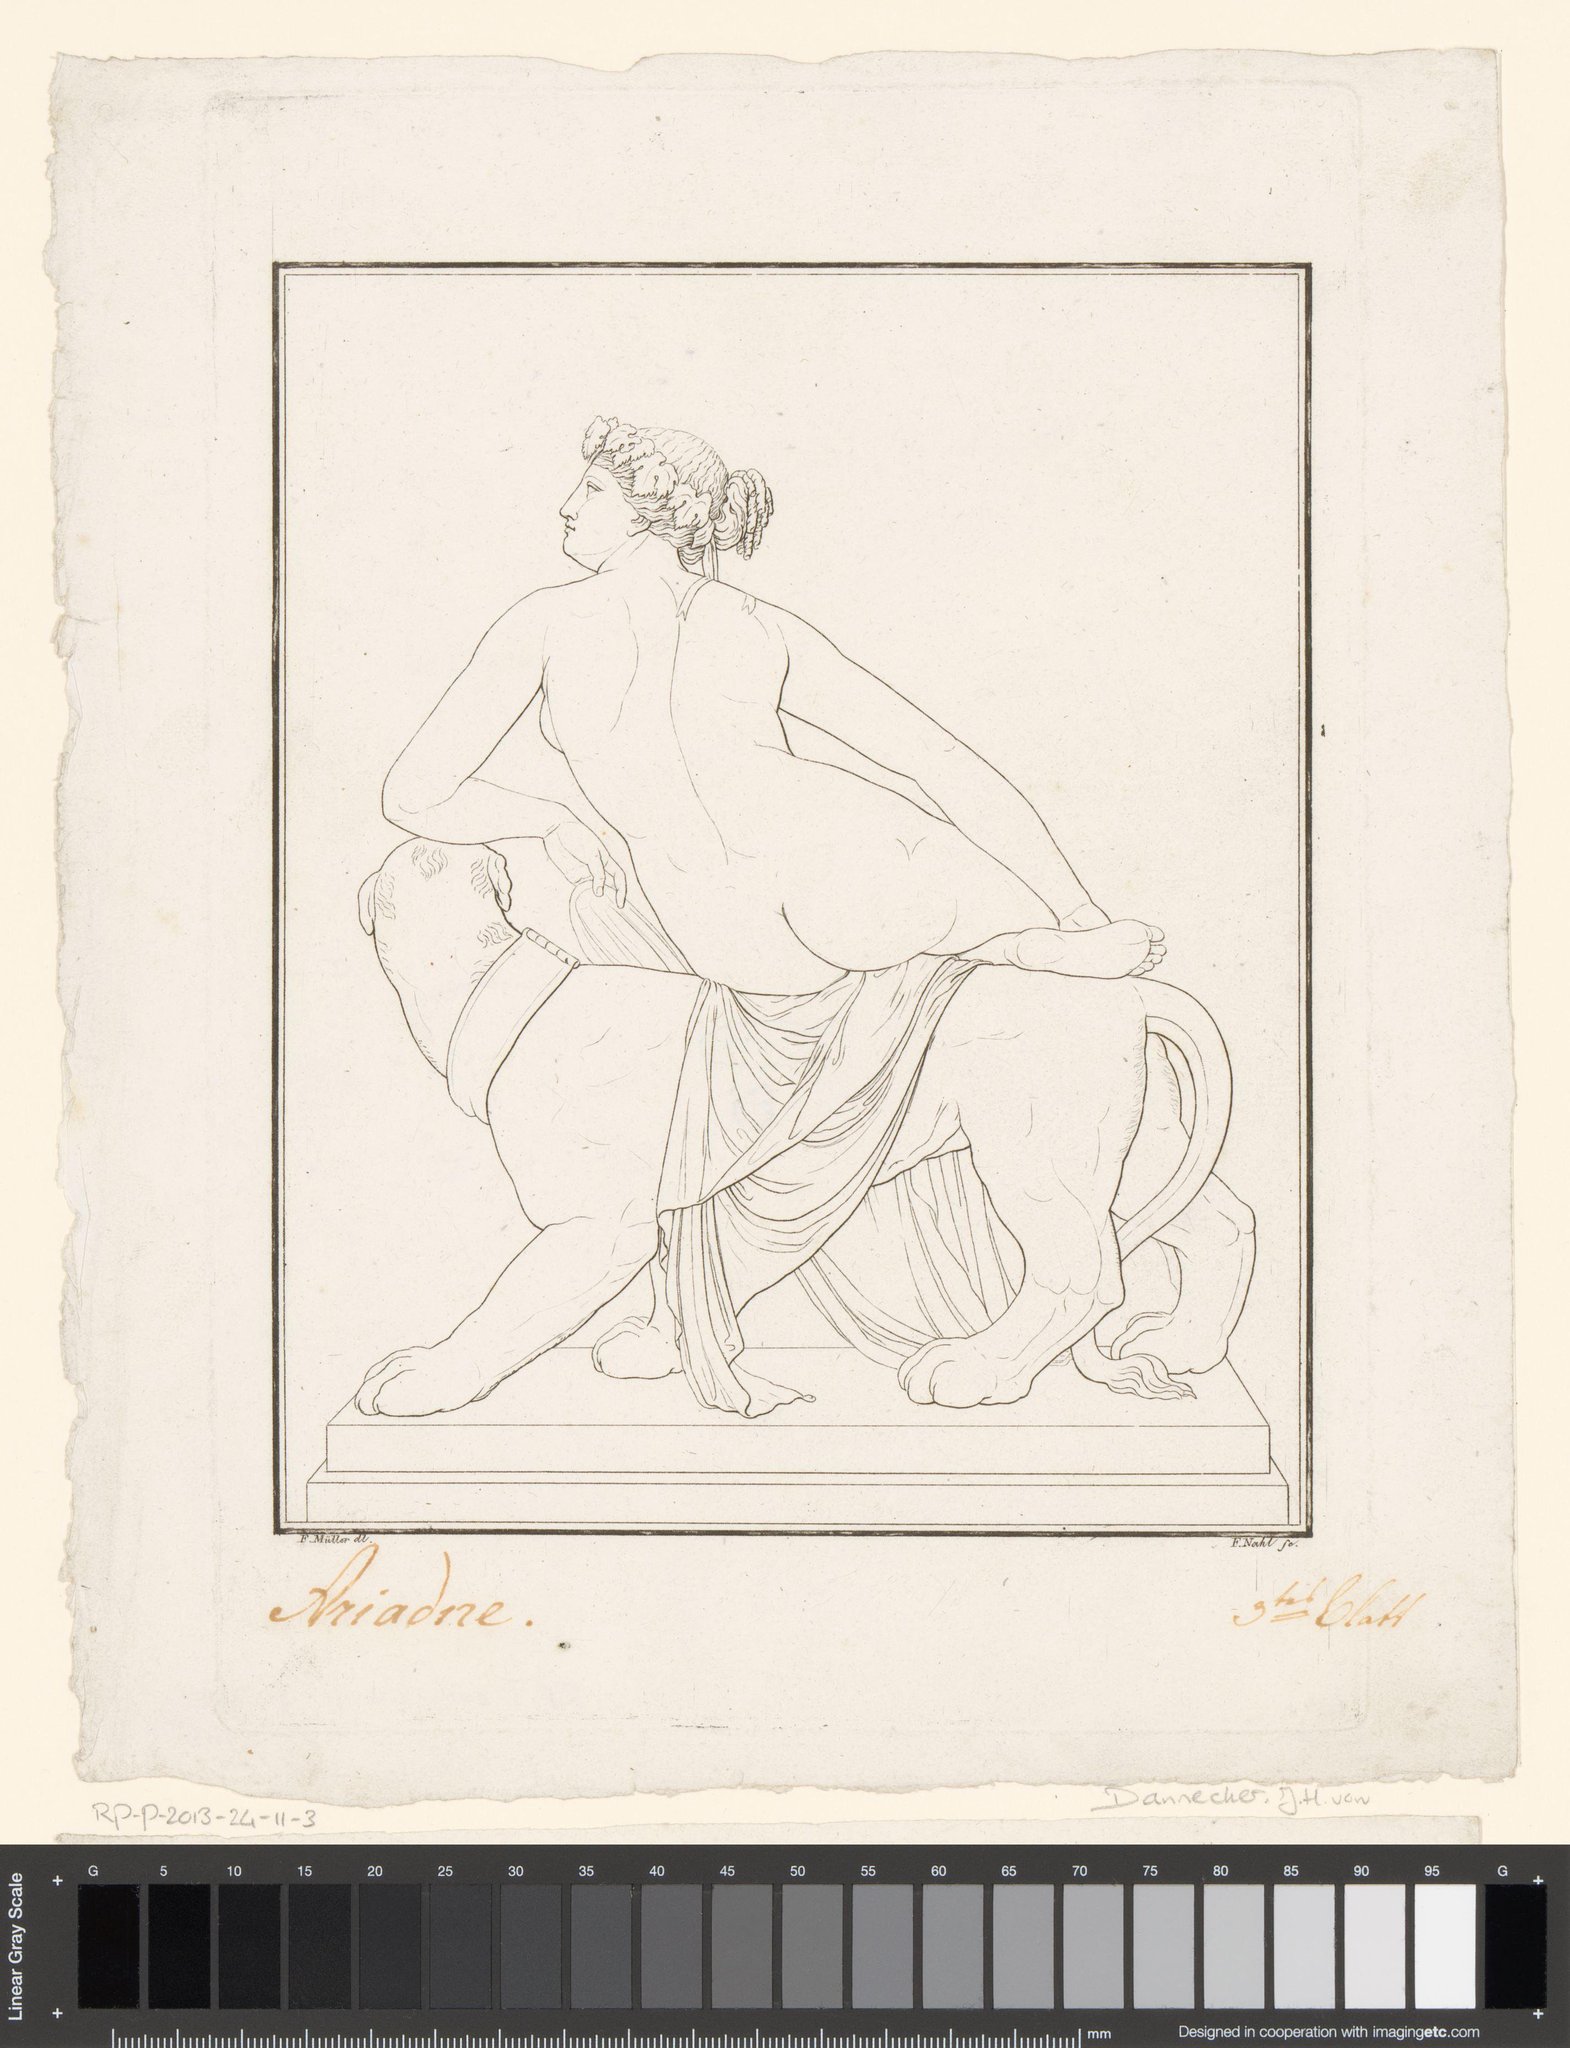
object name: print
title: Ariadne zittend op een panter; zijaanzicht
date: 1814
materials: paper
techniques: engraving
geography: germany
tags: ariadne left behind on the island of naxos, (story of) ariadne and bacchus, piece of sculpture, reproduction of a piece of sculpture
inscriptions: collector's mark: Lugt 2760, collector's mark: Lugt 2228, inscription: ‘Ariadne // 3tes Blatt’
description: Onderdeel van een serie van vier verschillende aanzichten van het beeldhouwwerk van Heinrich von Dannecker voorstellend Ariadne zittend op de panter. Het beeld bevindt zich nu in het Liebieghaus Skulpturensammlung, Frankfurt am Main.